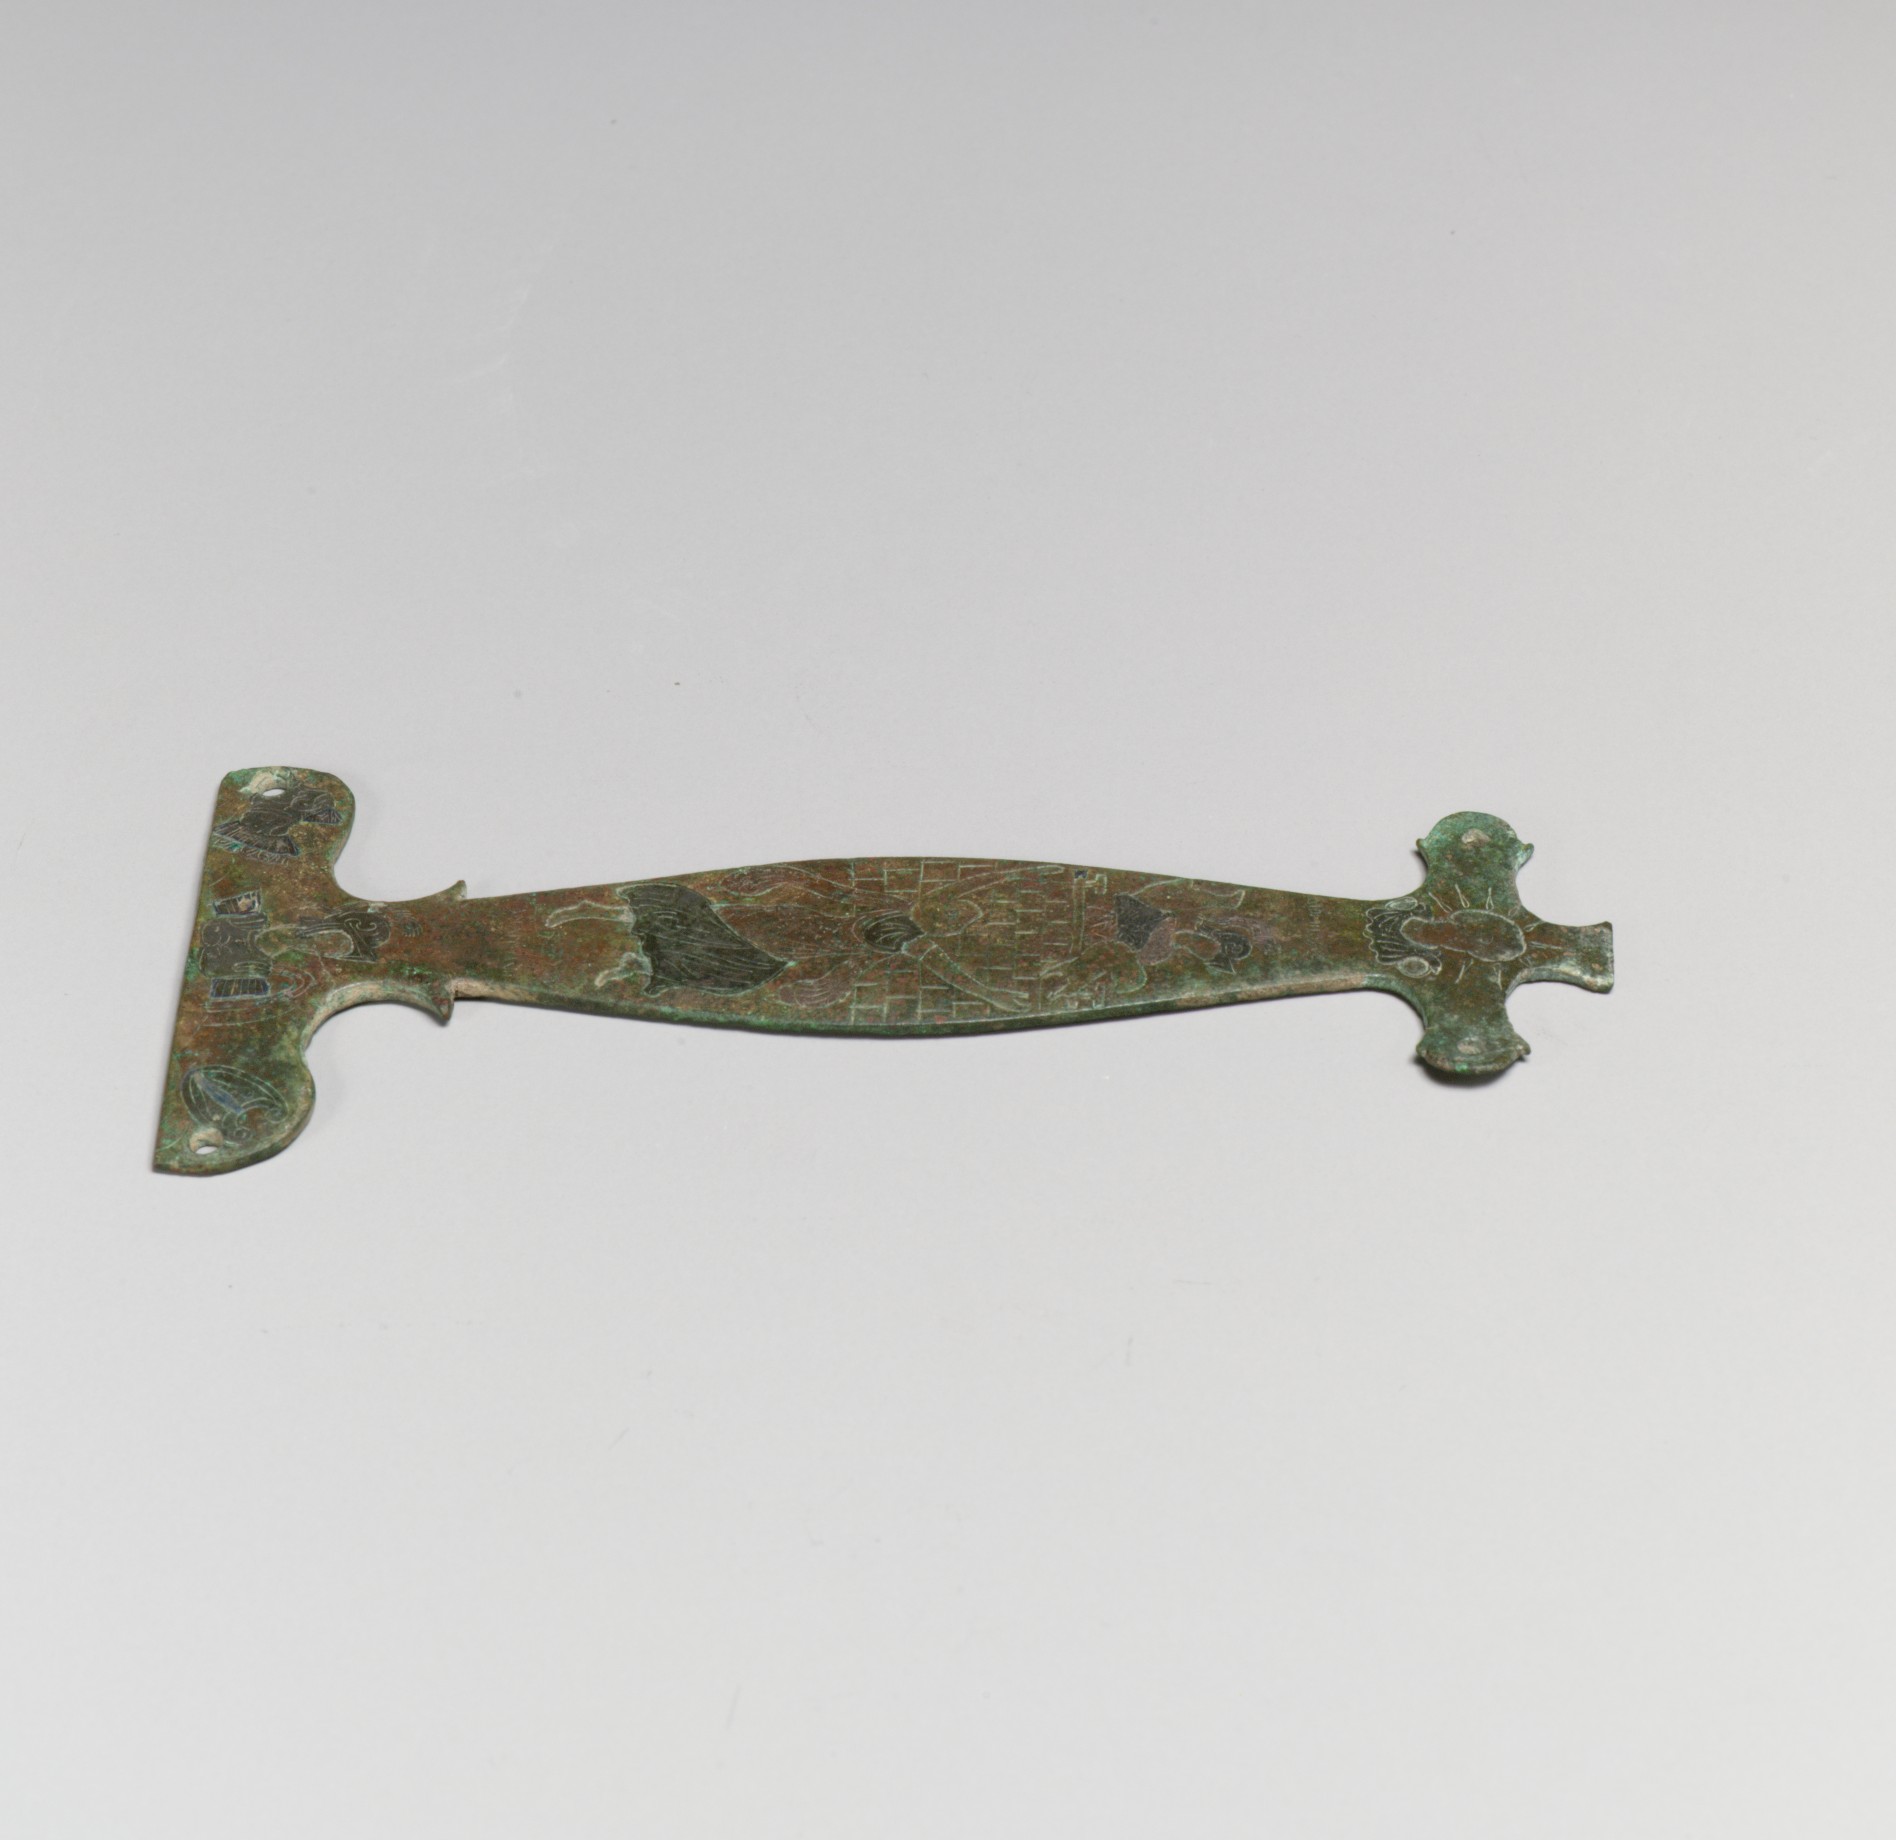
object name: appliqué with diomedes and andromache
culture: roman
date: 301-400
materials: bronze, silver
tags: andromache